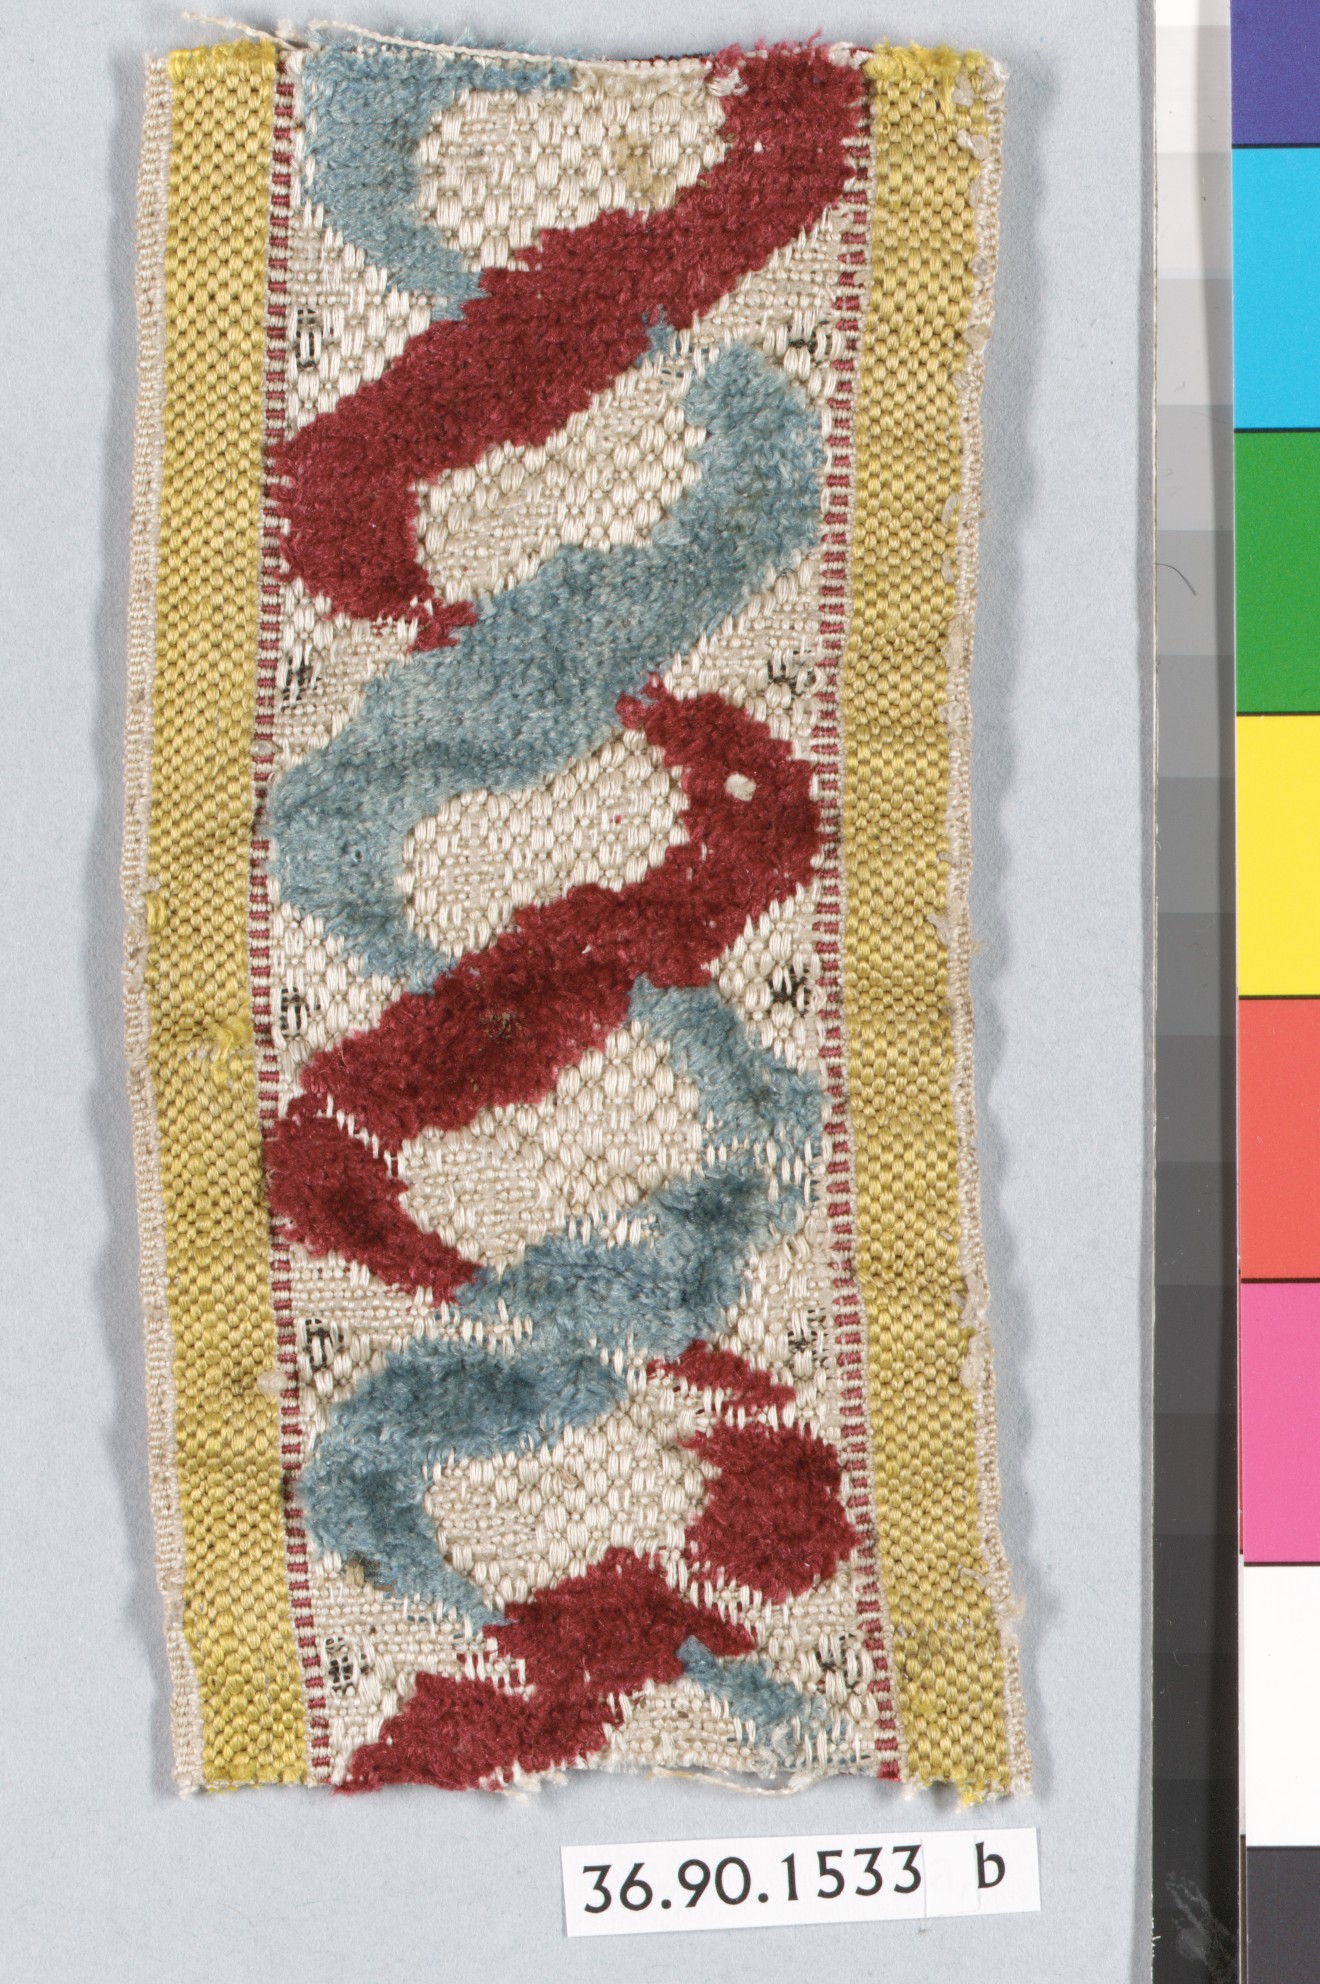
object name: galloon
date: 1701-1900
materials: silk